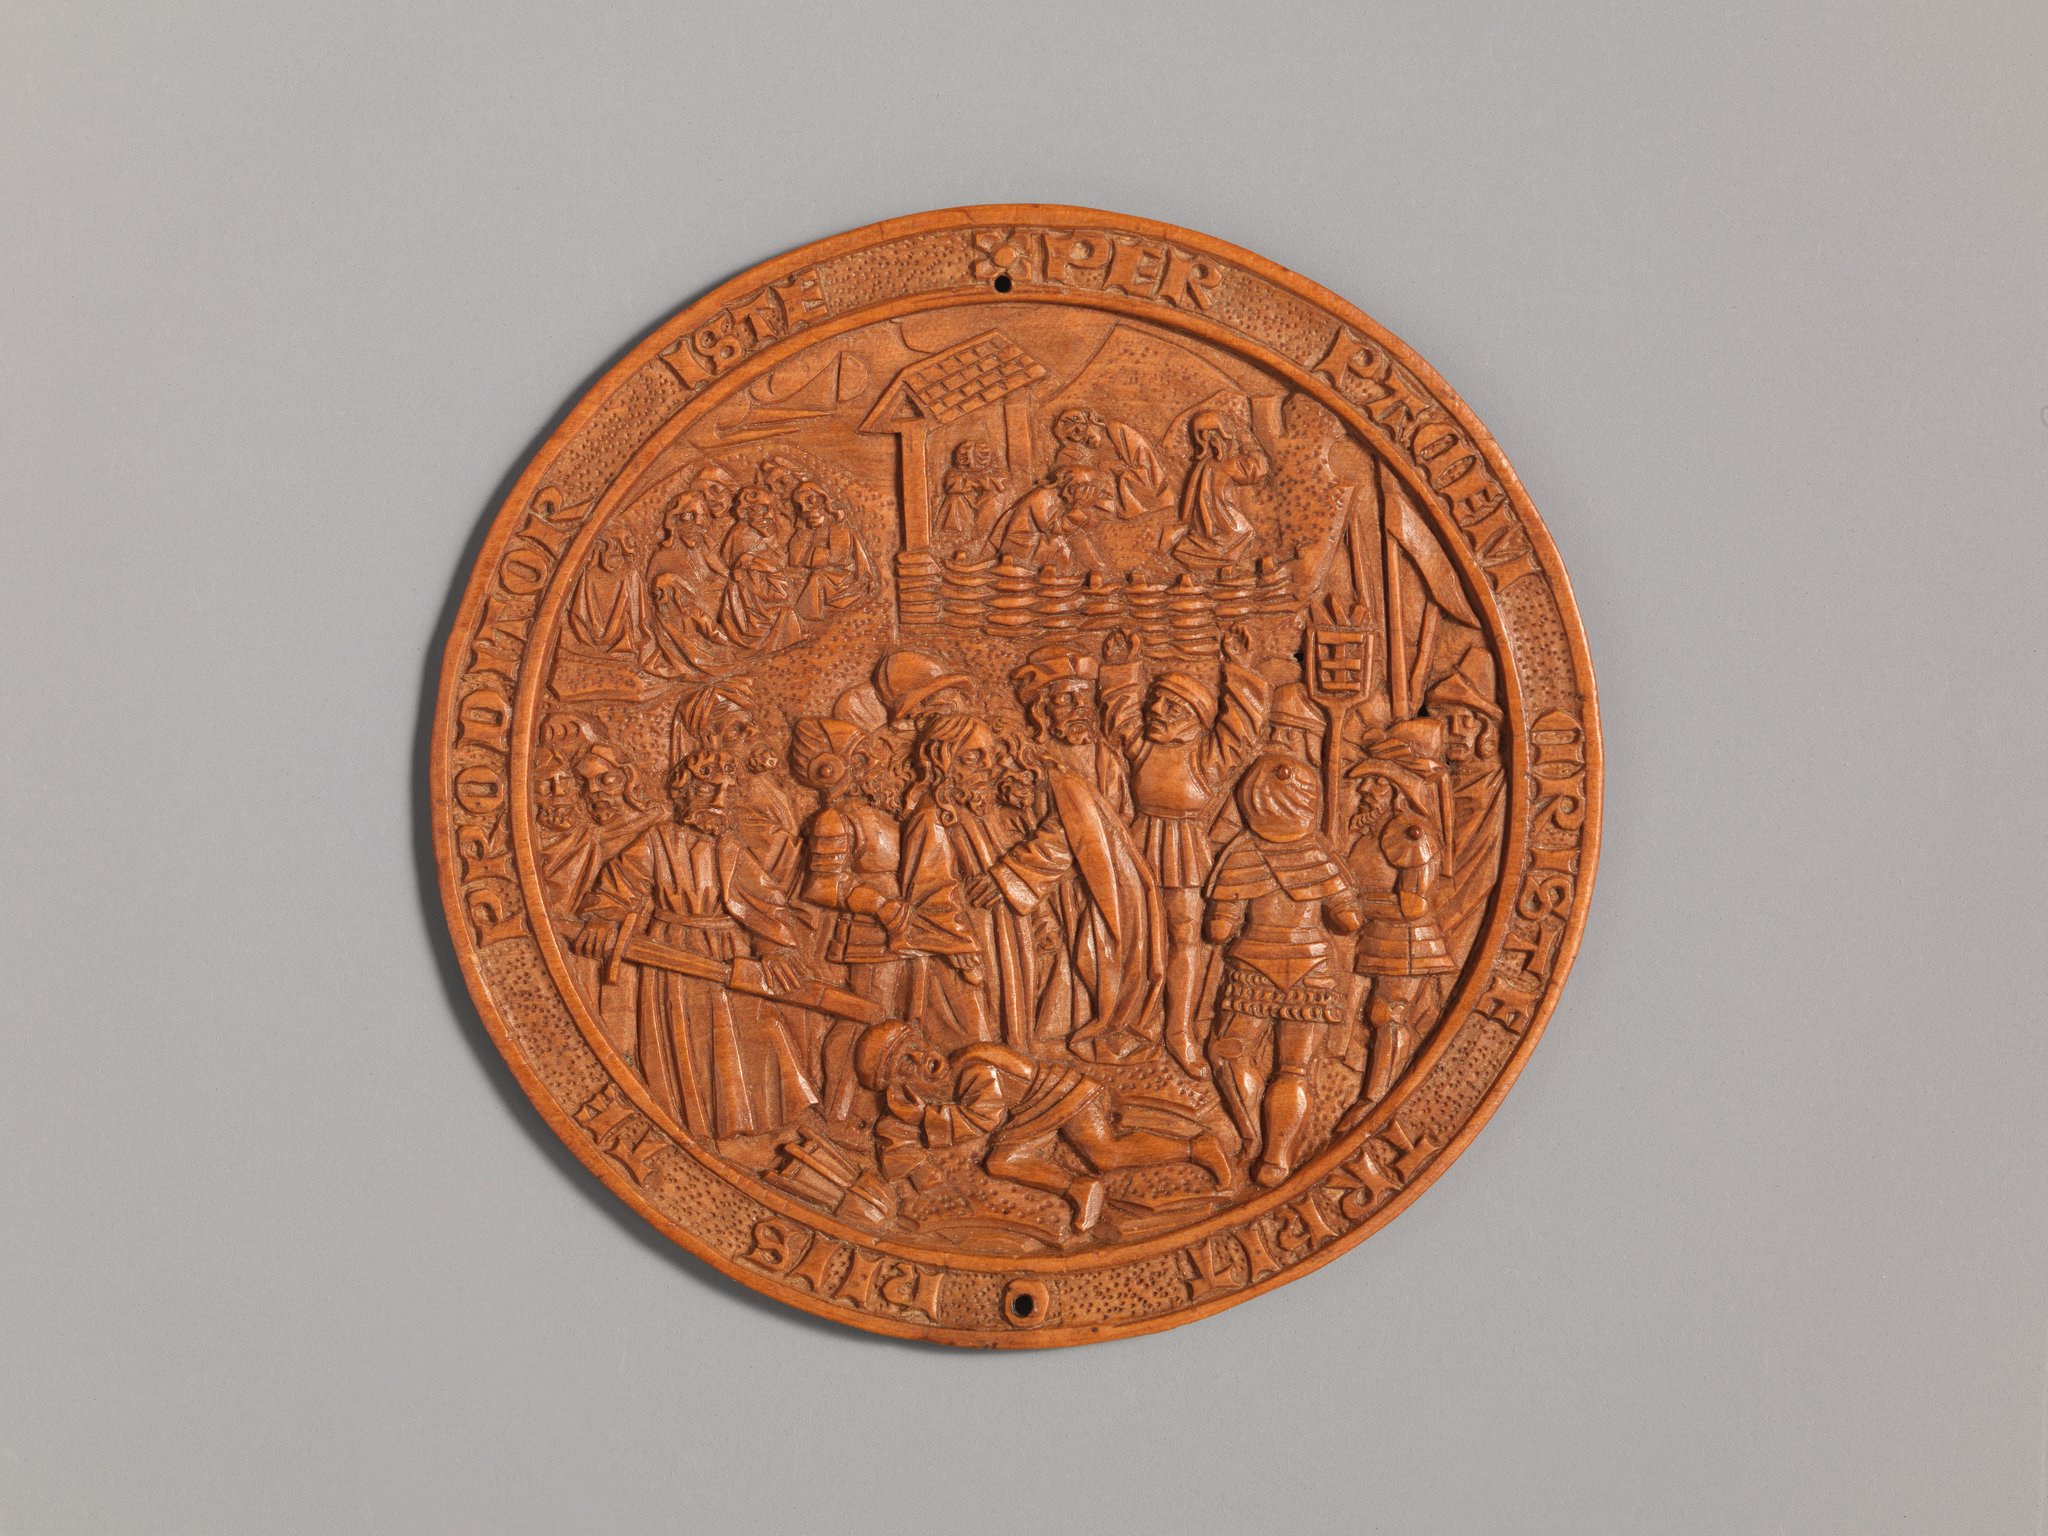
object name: medallion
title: Medallion with the Betrayal of Jesus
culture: dutch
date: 1501-1533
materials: wood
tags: soldiers,men,jesus,crowd